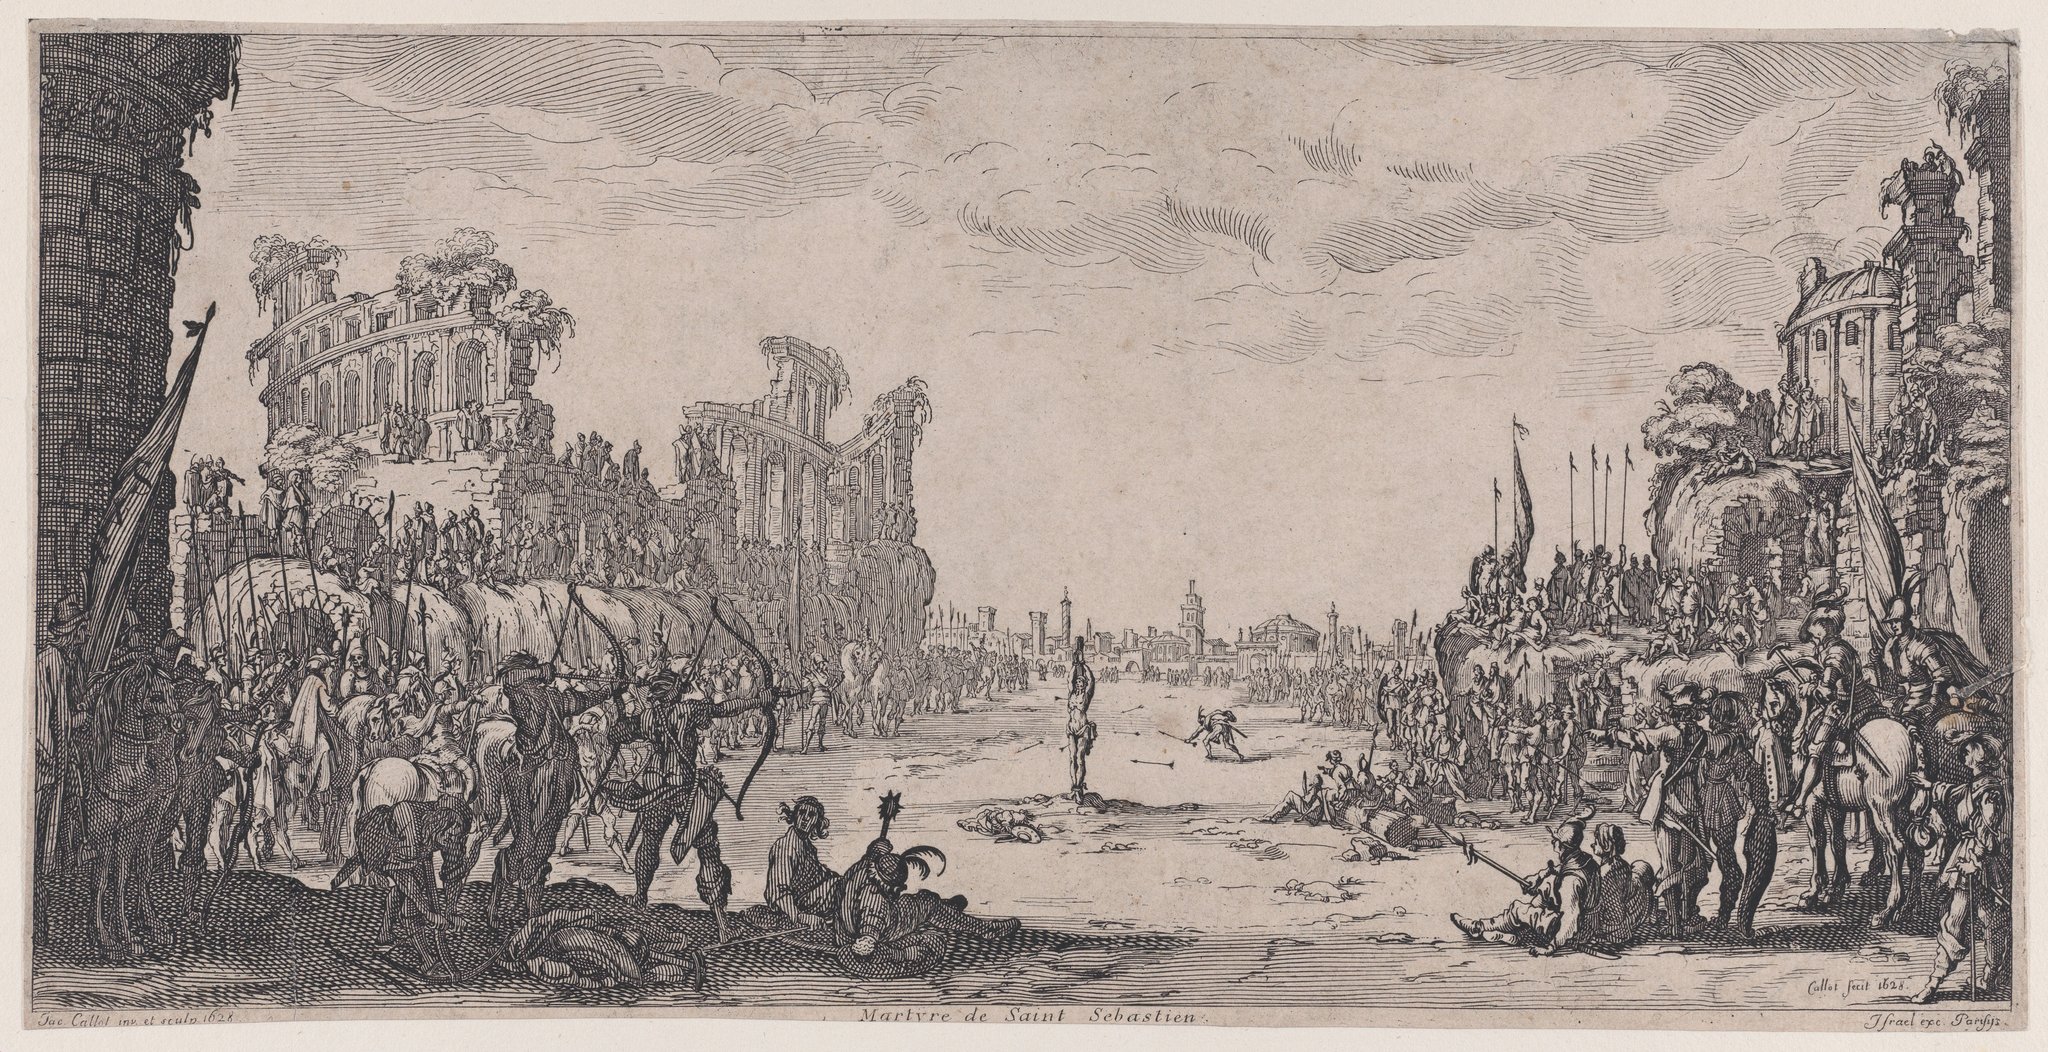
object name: print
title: Copy of Le Martyre de St. Sébastien (The Martyrdom of St. Sebastian)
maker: Anonymous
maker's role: artist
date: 1601-1700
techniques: etching